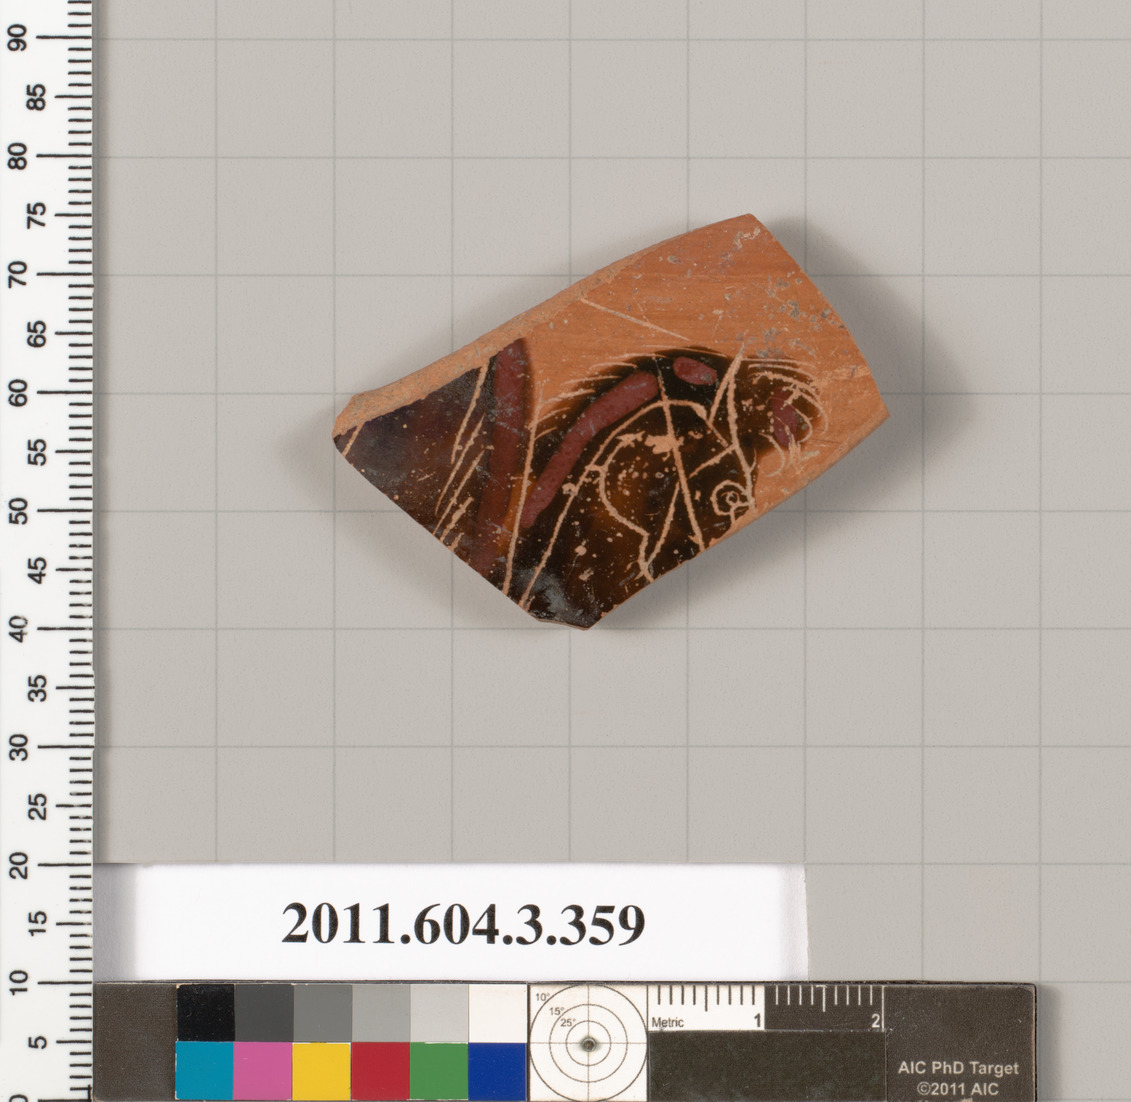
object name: neck amphora fragment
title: Terracotta fragment of a neck-amphora (jar)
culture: greek, attic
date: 525-501 BCE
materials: terracotta